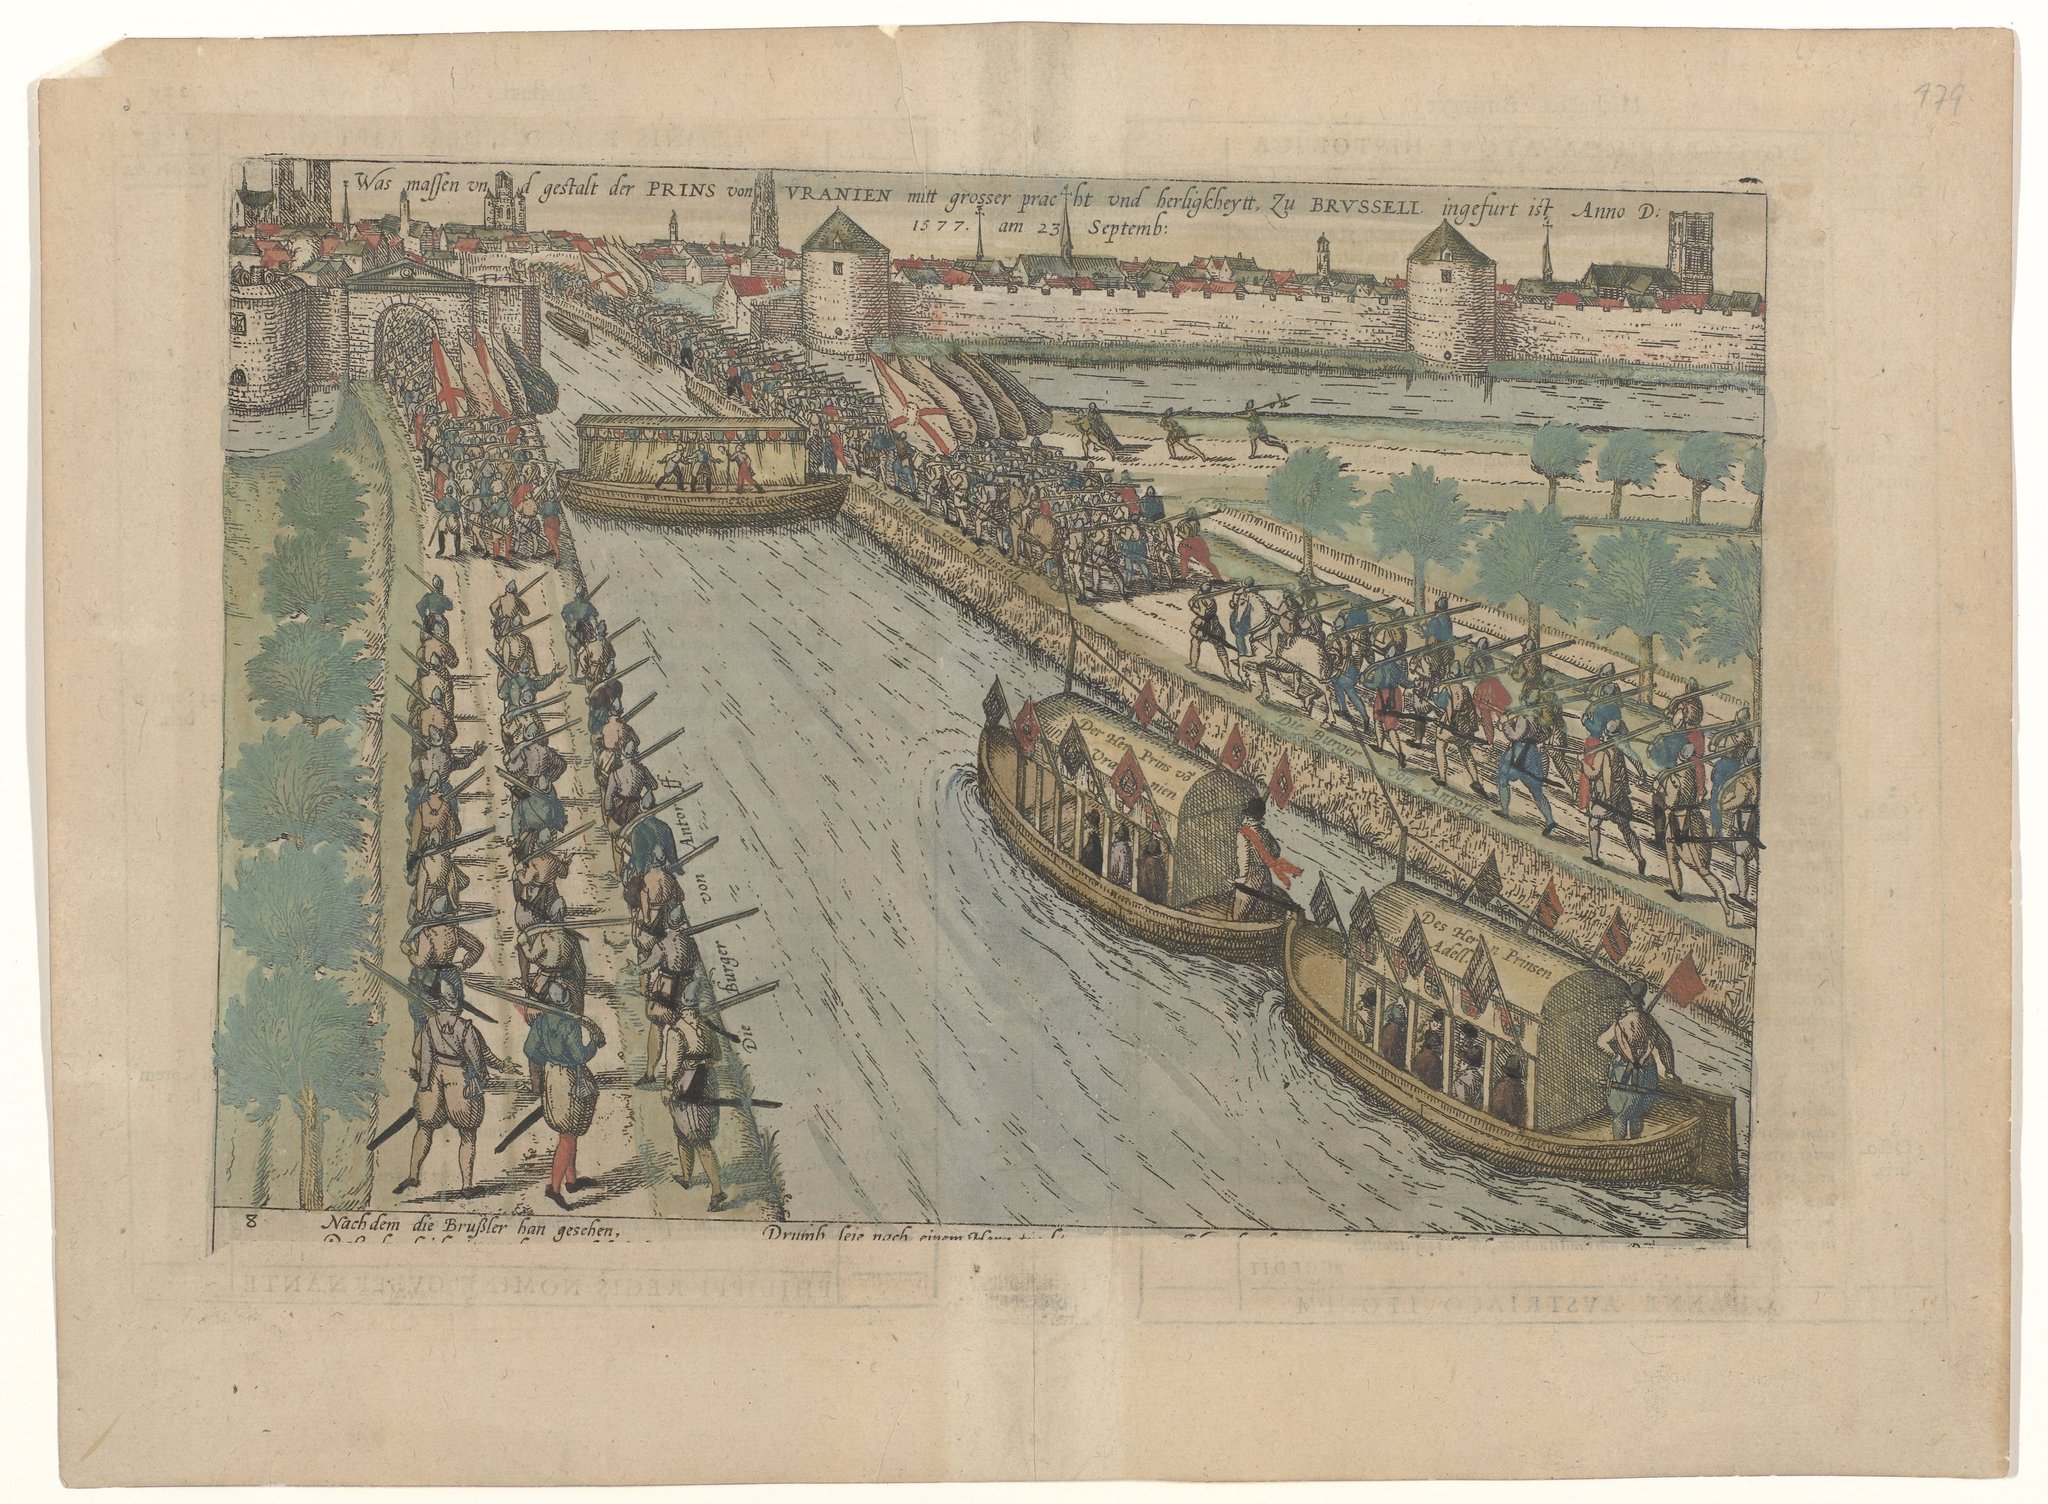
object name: print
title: Serie 8: Nederlandse Gebeurtenissen, 1577-1583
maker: frans hogenberg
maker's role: print maker, publisher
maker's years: 1538-1590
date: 1588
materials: paper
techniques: colour, etching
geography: cologne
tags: delft, william i (prince of orange), triumphal entry and public reception, pageant, 'entrée solennelle', 'joyeuse entrée', brussels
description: Feestelijke intocht van de prins Willem van Oranje te Brussel, 23 september 1577. Willem van Oranje in een trekschuit en begeleid door ruiters en soldaten uit Antwerpen en Brussel de stad ingeleid. Gedrukt met een cache over het onderschrift.